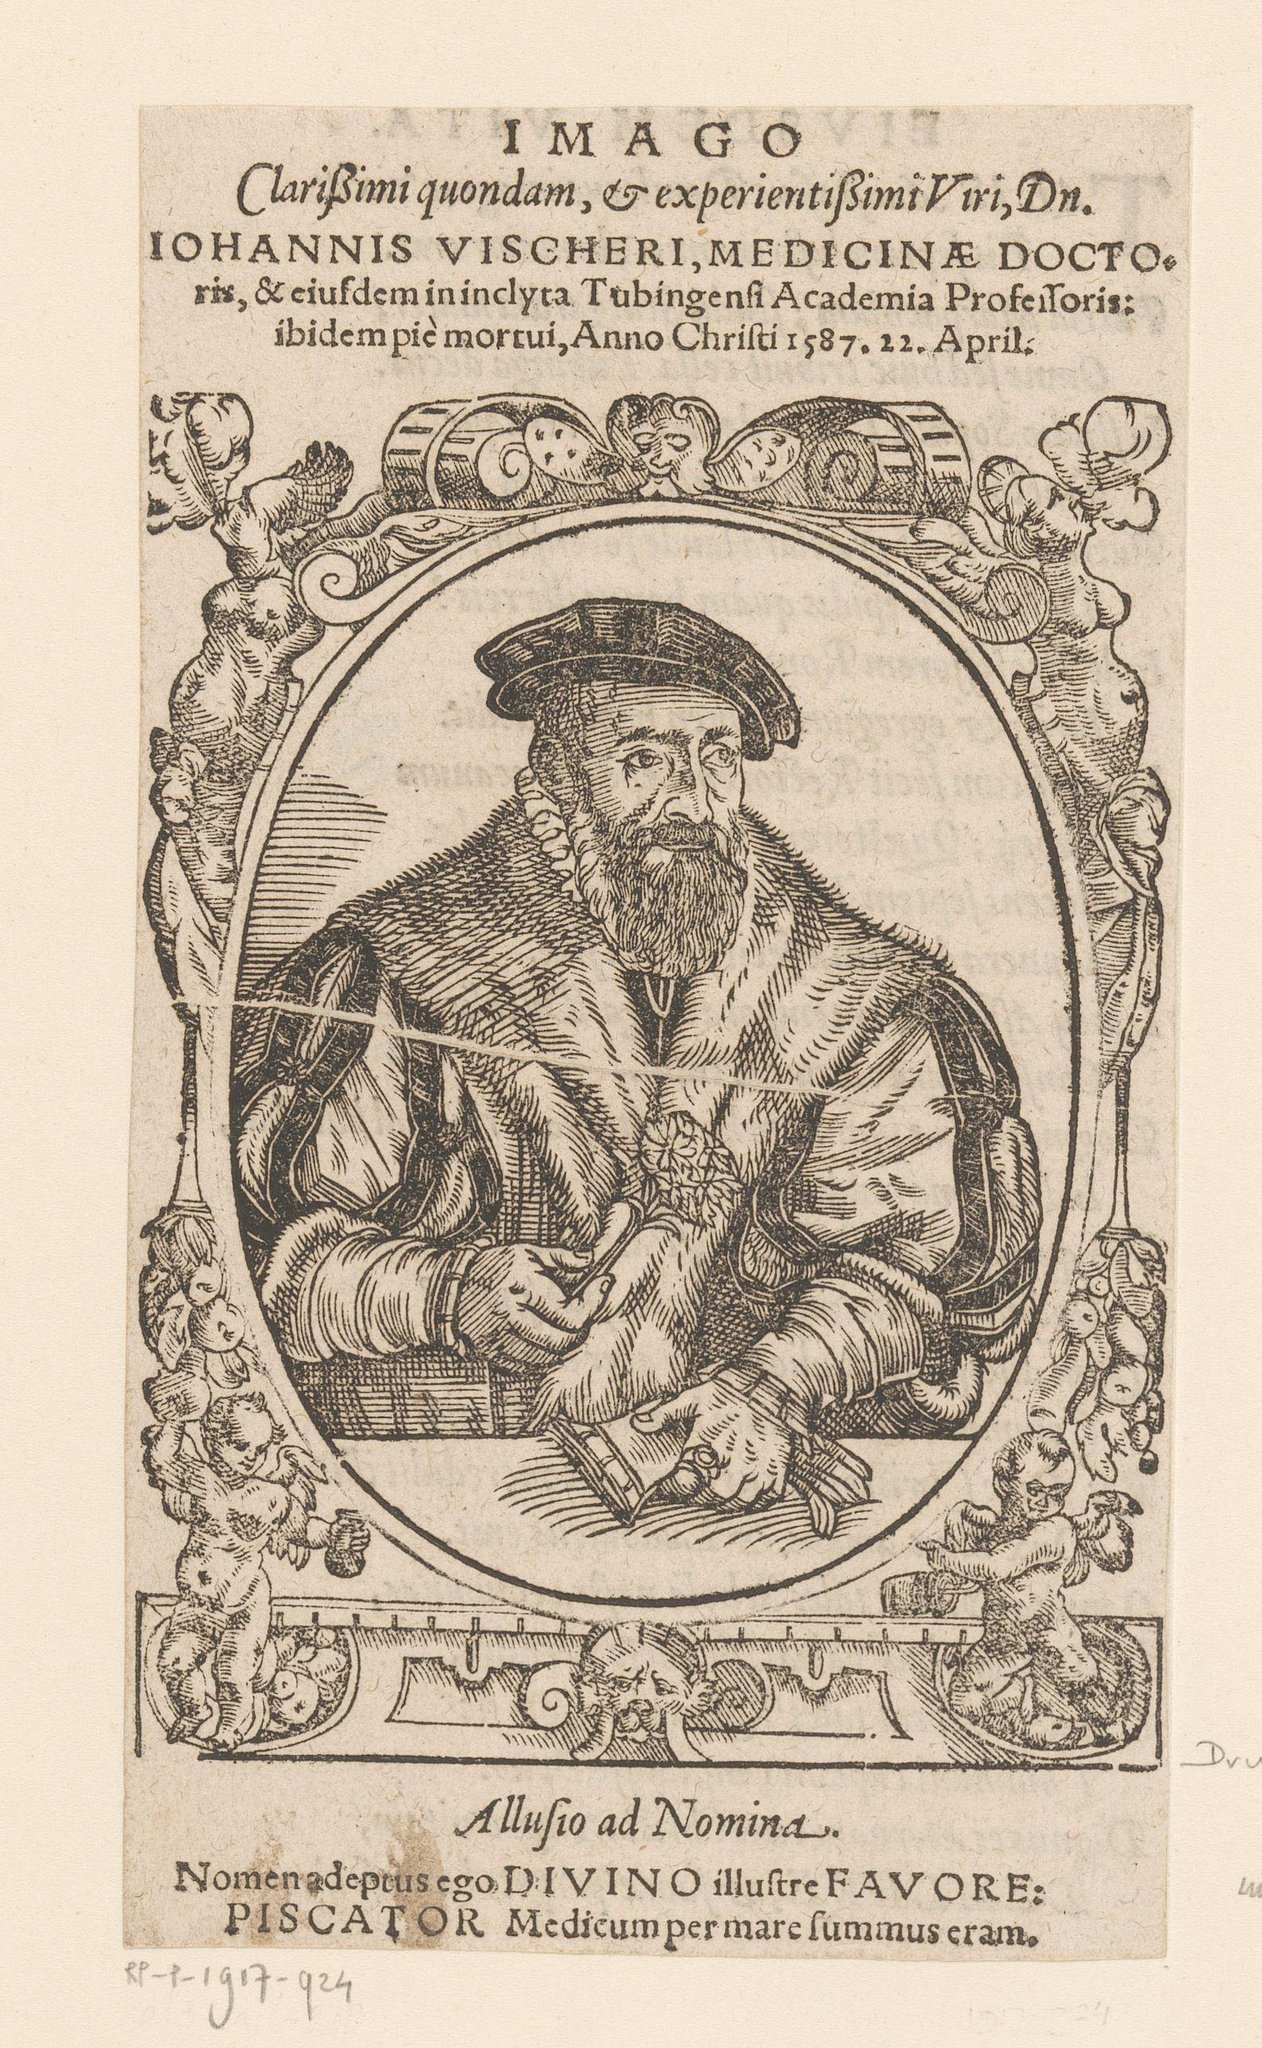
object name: print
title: Portret van Johannes Vischer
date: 1596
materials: paper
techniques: letterpress printing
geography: tübingen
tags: flowers, caryatids ~ architecture, gloves, mittens, etc., historical persons, cupids: 'amores', 'amoretti', 'putti'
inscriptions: collector's mark: Lugt 2228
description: Prent gebruikt voor de publicatie: Cellius, Erhard. Imagines professorum Tubingensium. Tübingen: Erhard Cellius, 1596, p. [108].